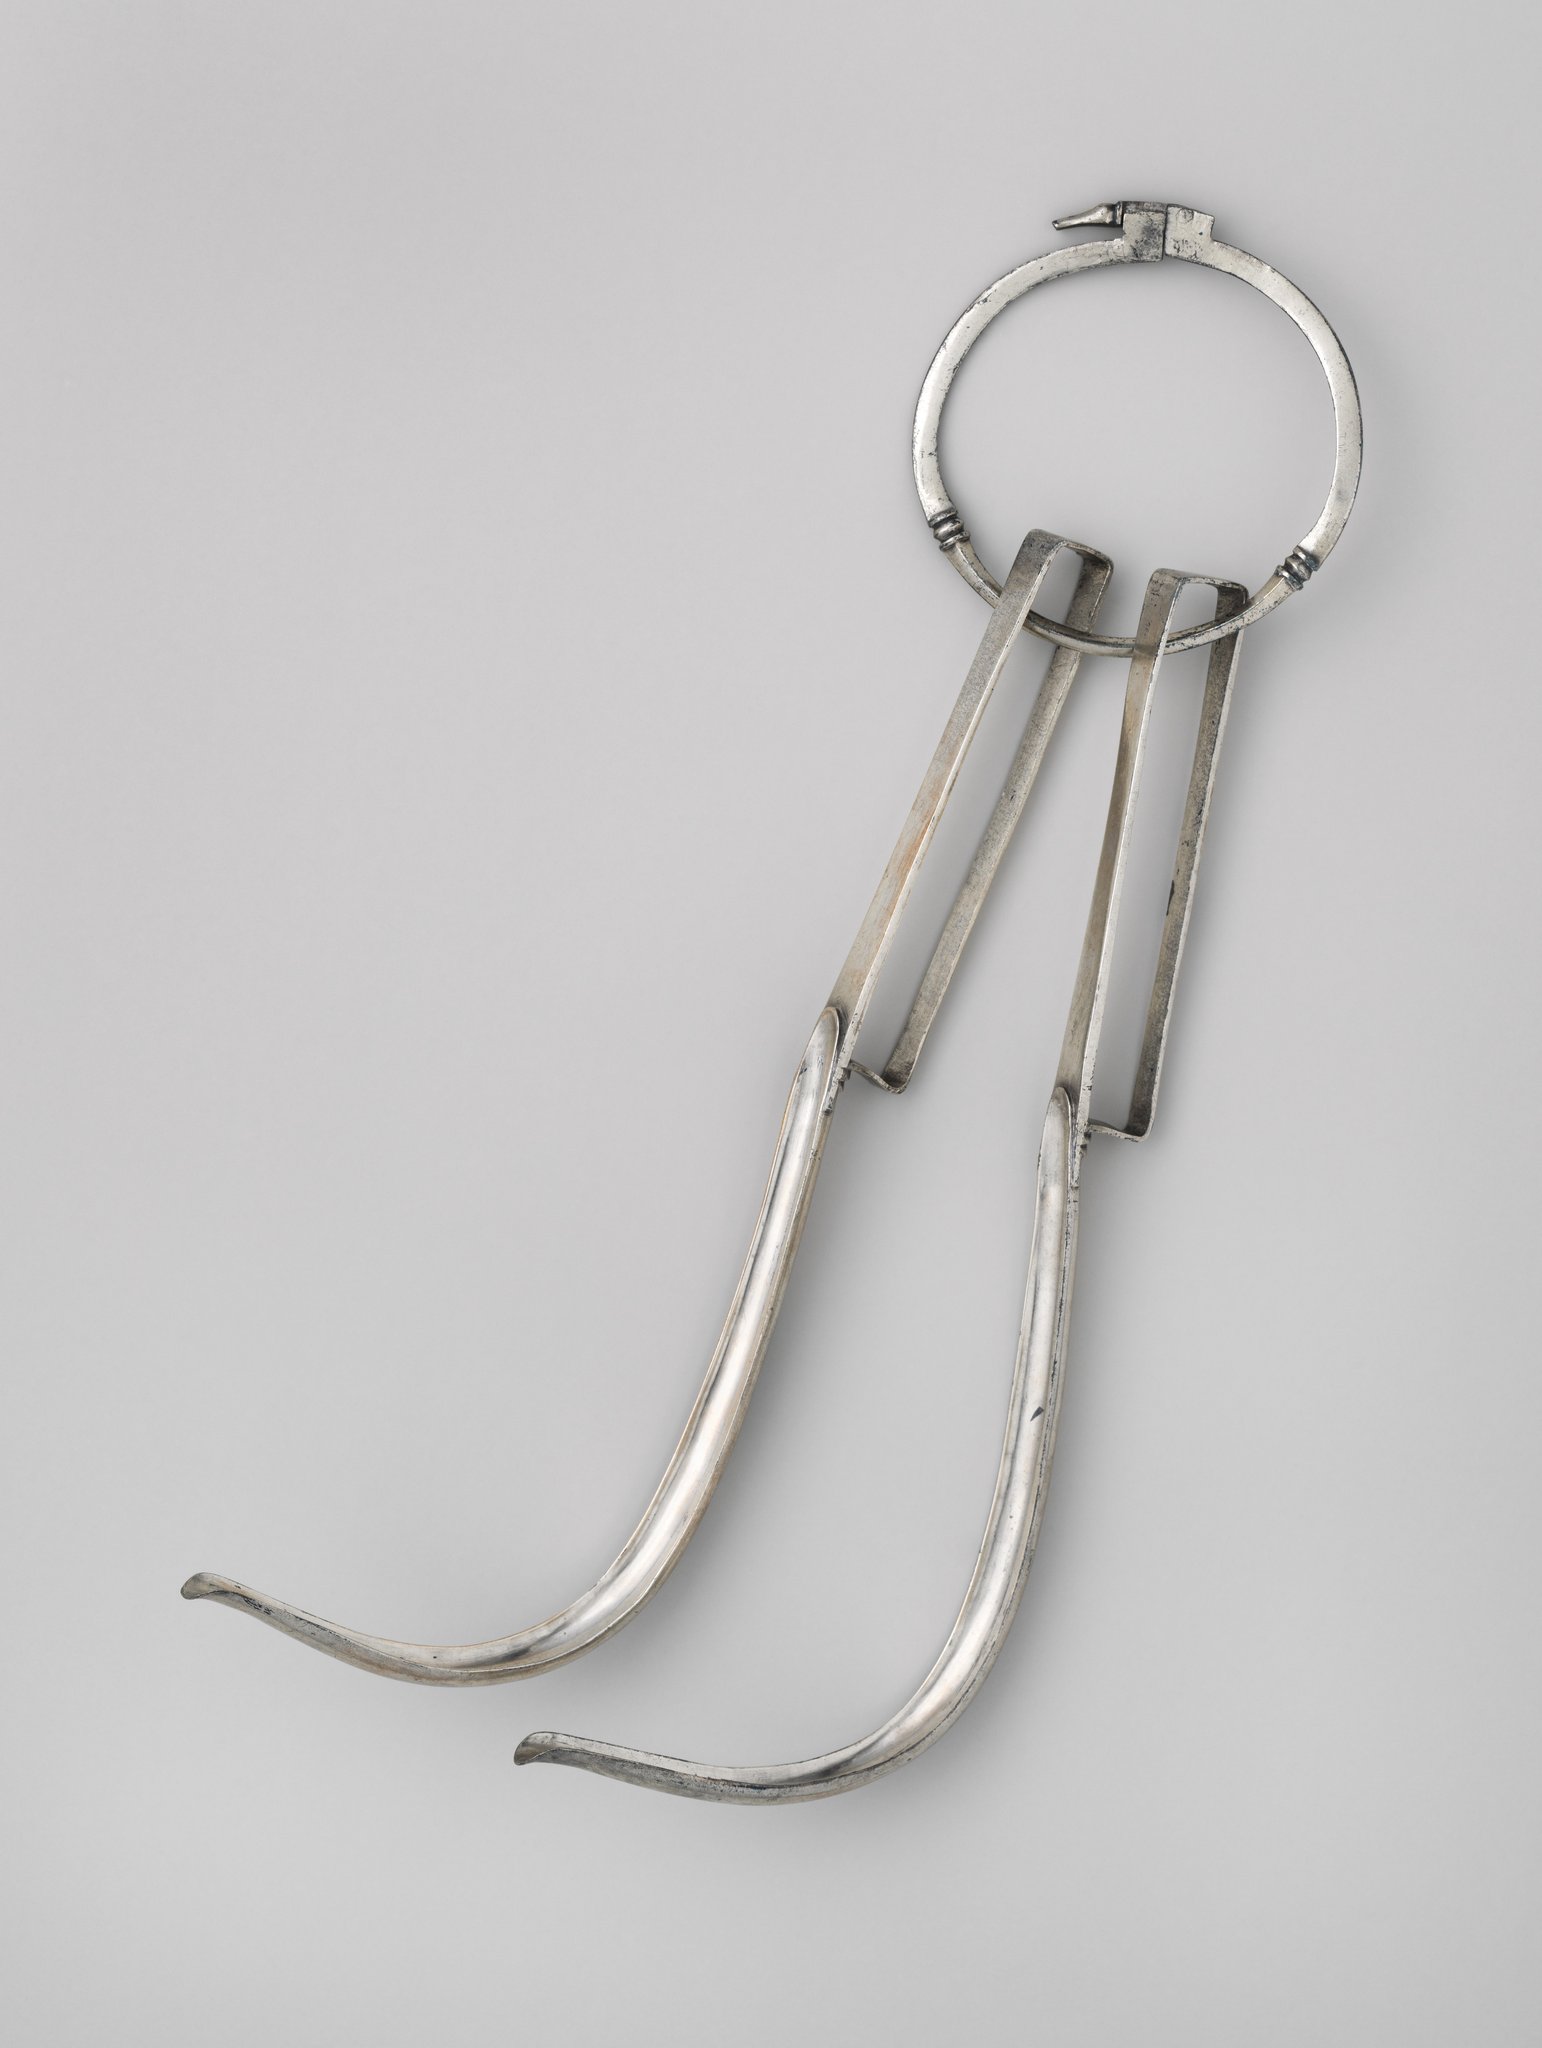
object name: strigils on a silver ring, 2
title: Pair of silver strigils (scrapers) on a carrying ring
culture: roman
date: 67-35 BCE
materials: silver